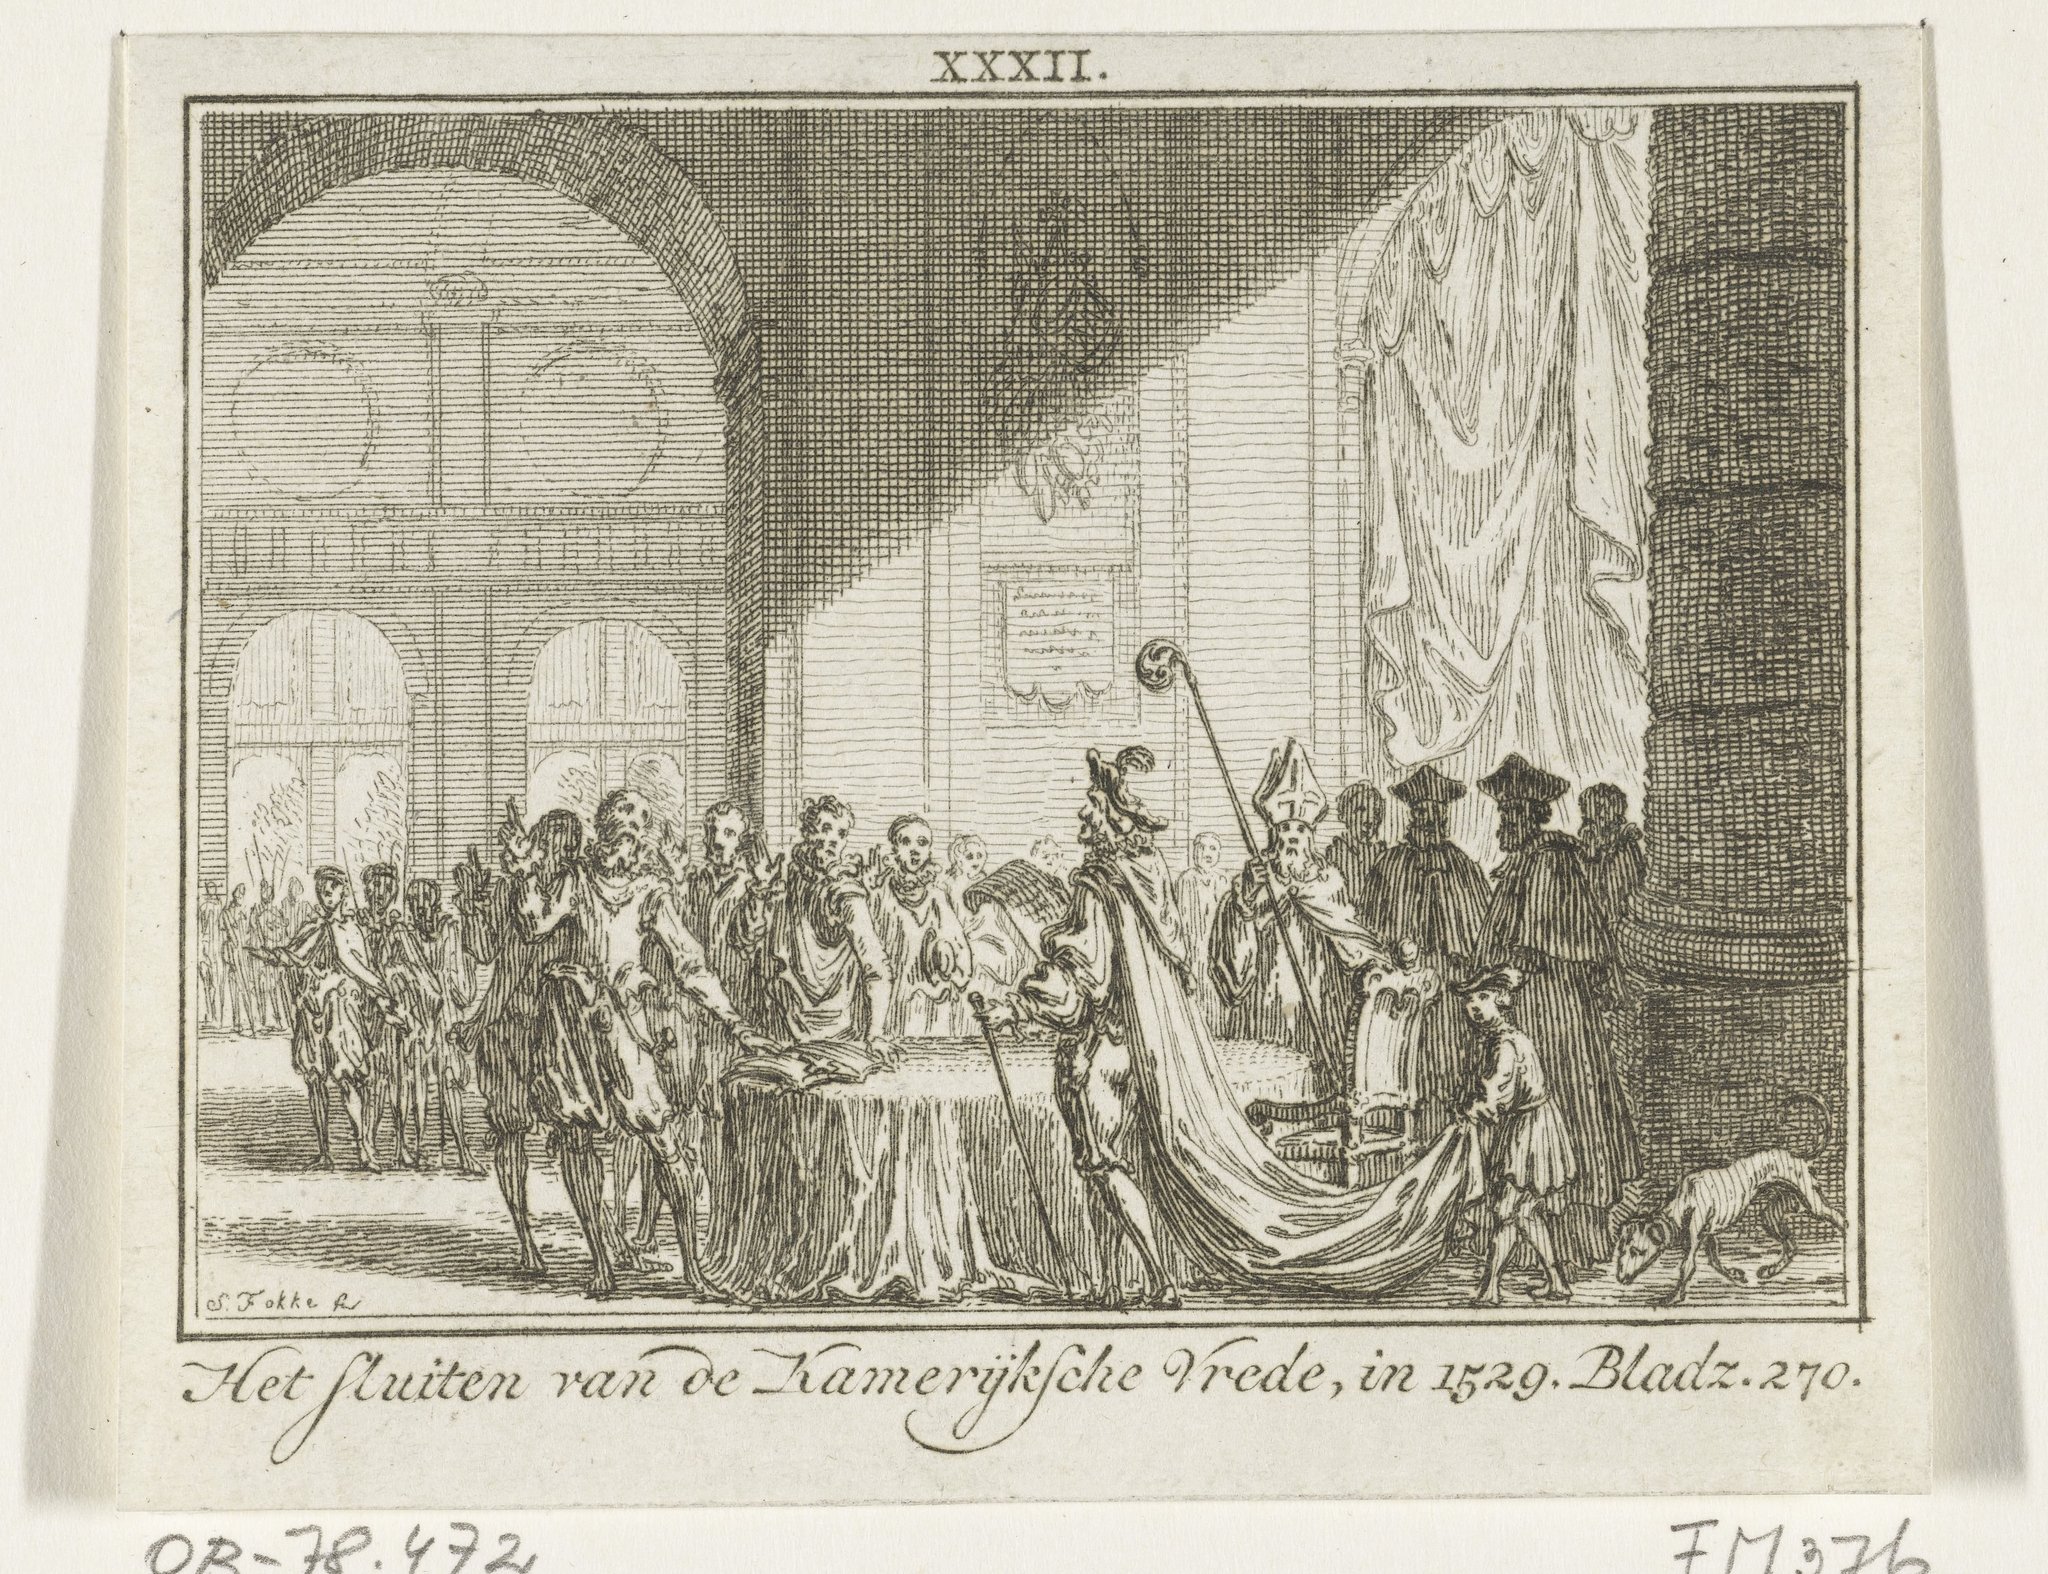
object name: history print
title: Het sluiten van de Kamerijksche Vrede, in 1529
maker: simon fokke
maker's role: draughtsman, print maker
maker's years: 1712-1784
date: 1782-1784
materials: paper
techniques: etching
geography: northern netherlands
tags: frans i van valois-angoulême (koning van frankrijk), ghent, charles v (holy roman emperor and king of spain), signing of peace treaty, concluding the peace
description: Illustratie voor: J.W. te Water, De vaderlandsche Historie van den heere J. Wagenaar, verkort, en met leerzaame aanmerkingen, ten dienste der Nederlandsche jeugd, 1784-1800, 4 delen, p. 270, pl. XXXII.